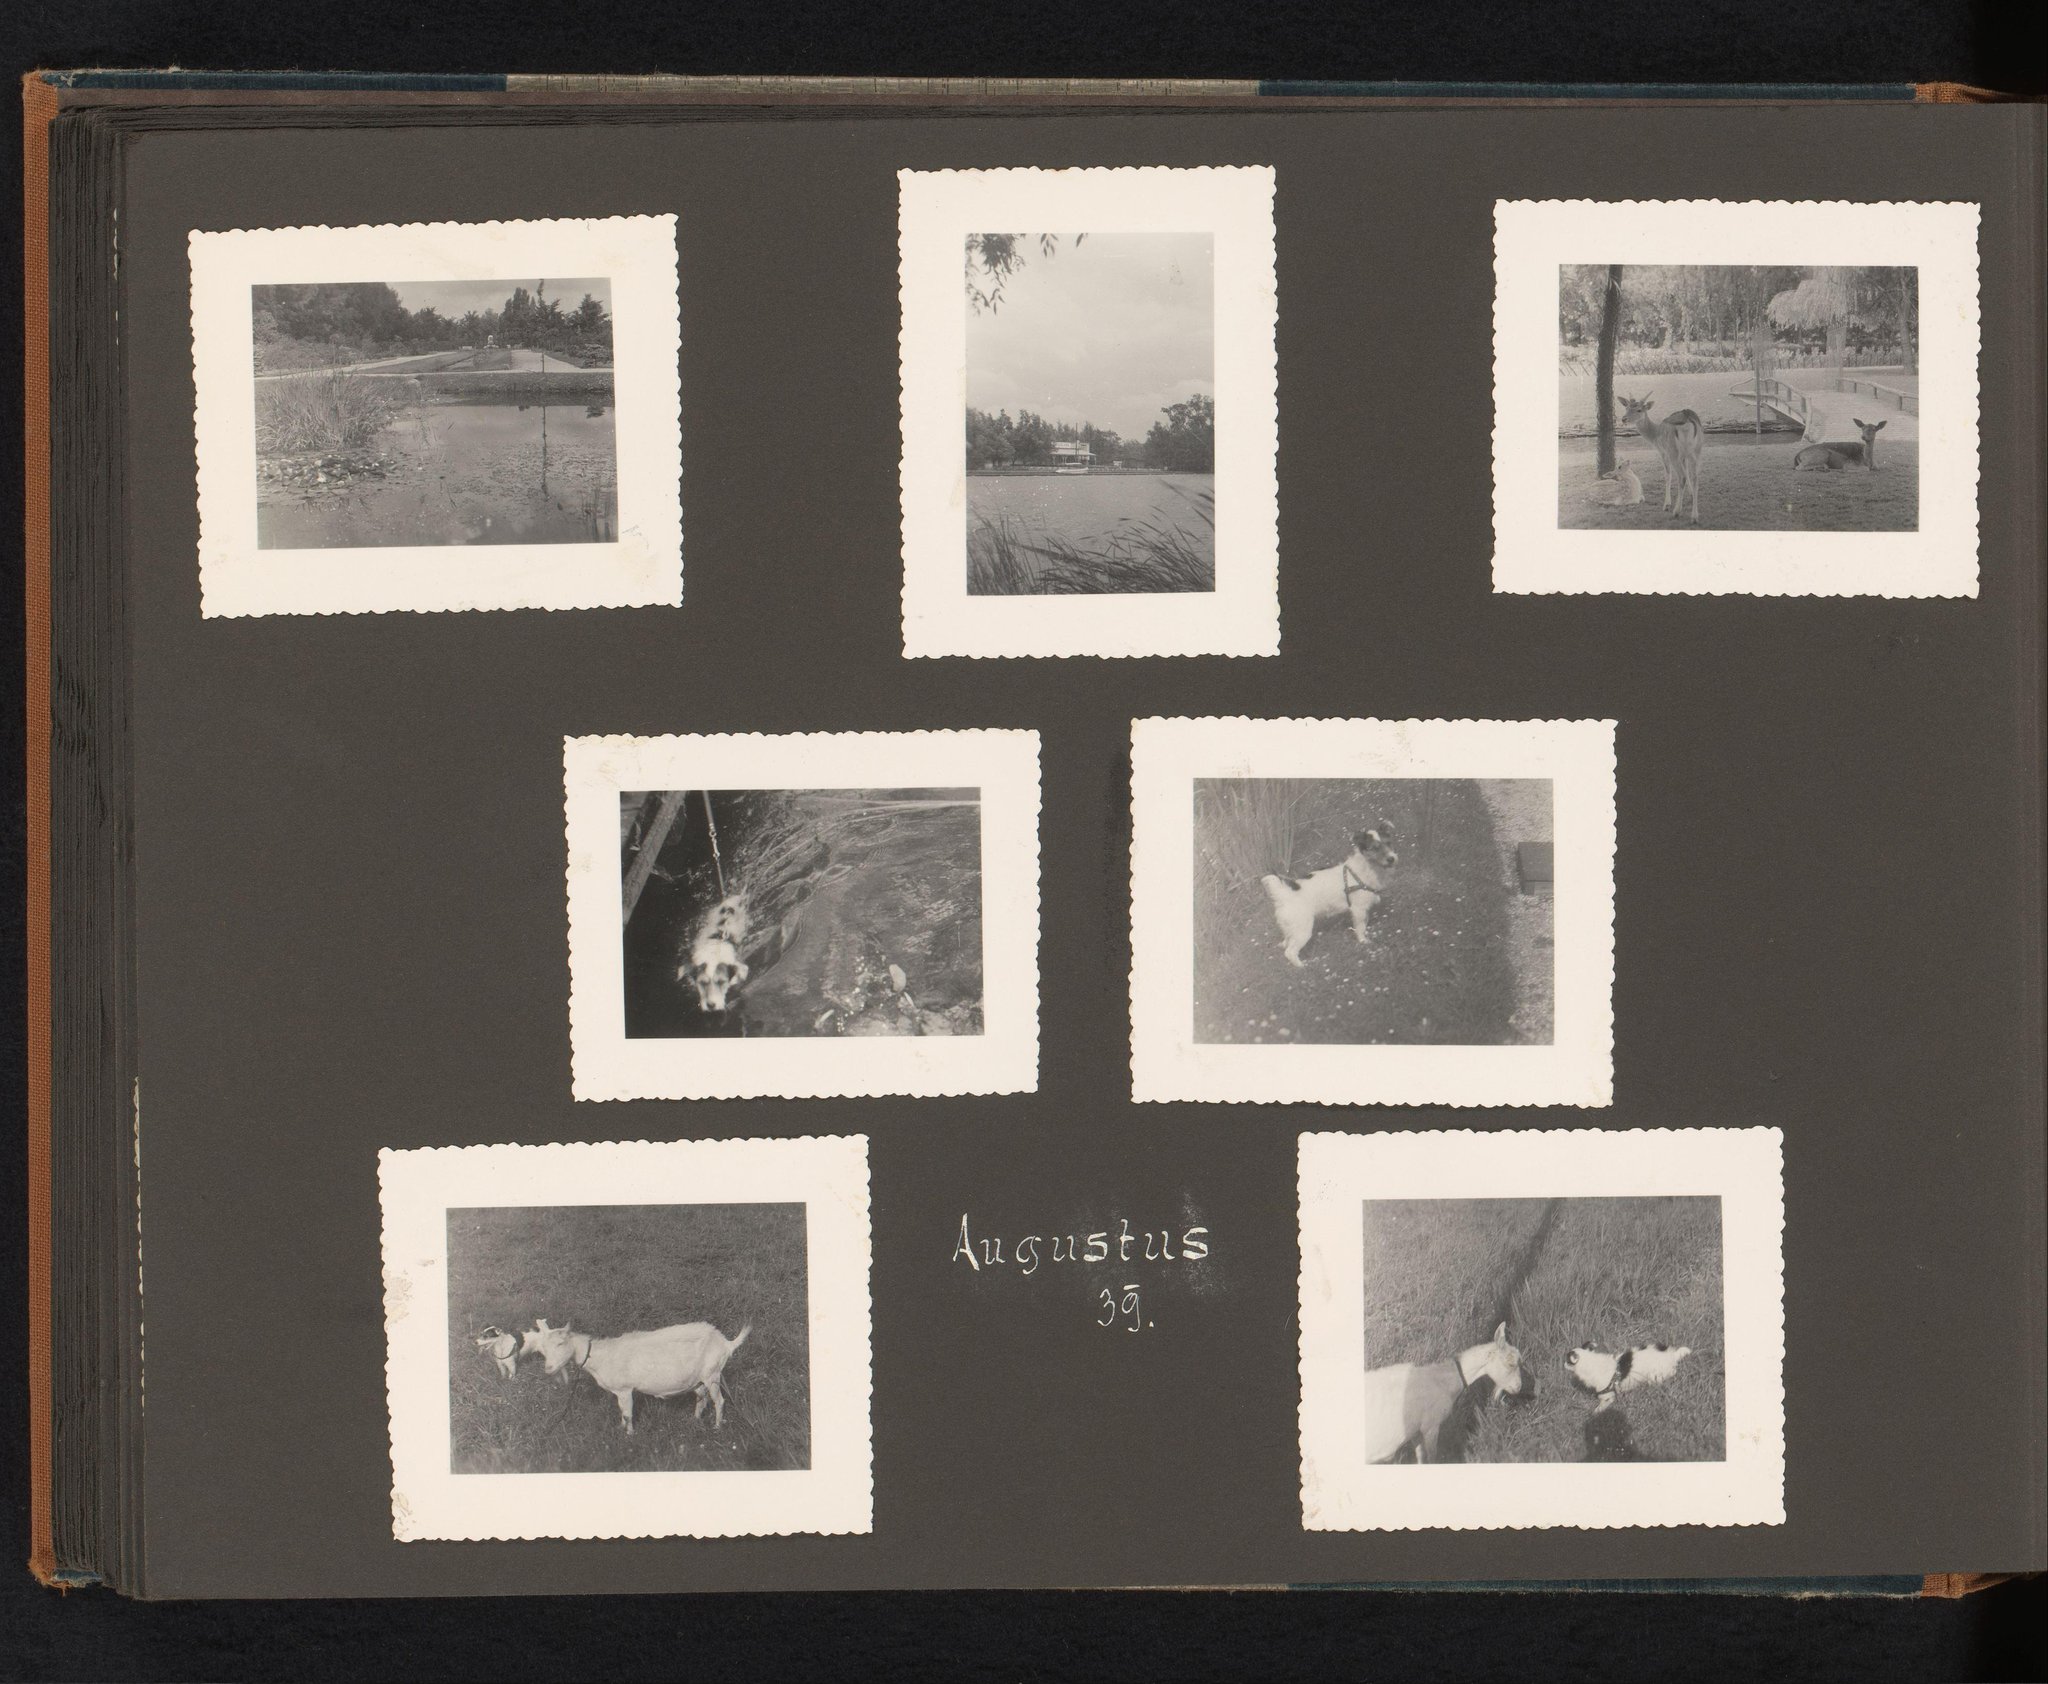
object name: album leaf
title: Landschappen te Rotterdam en de hond Bessie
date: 1908-1939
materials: cardboard, paper, photographic support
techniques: gelatin silver print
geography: rotterdam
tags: interior of the house, dog, rotterdam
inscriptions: date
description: Zeven foto's met de hond Bessie te Rotterdam. Deze pagina maakt deel uit van een album.